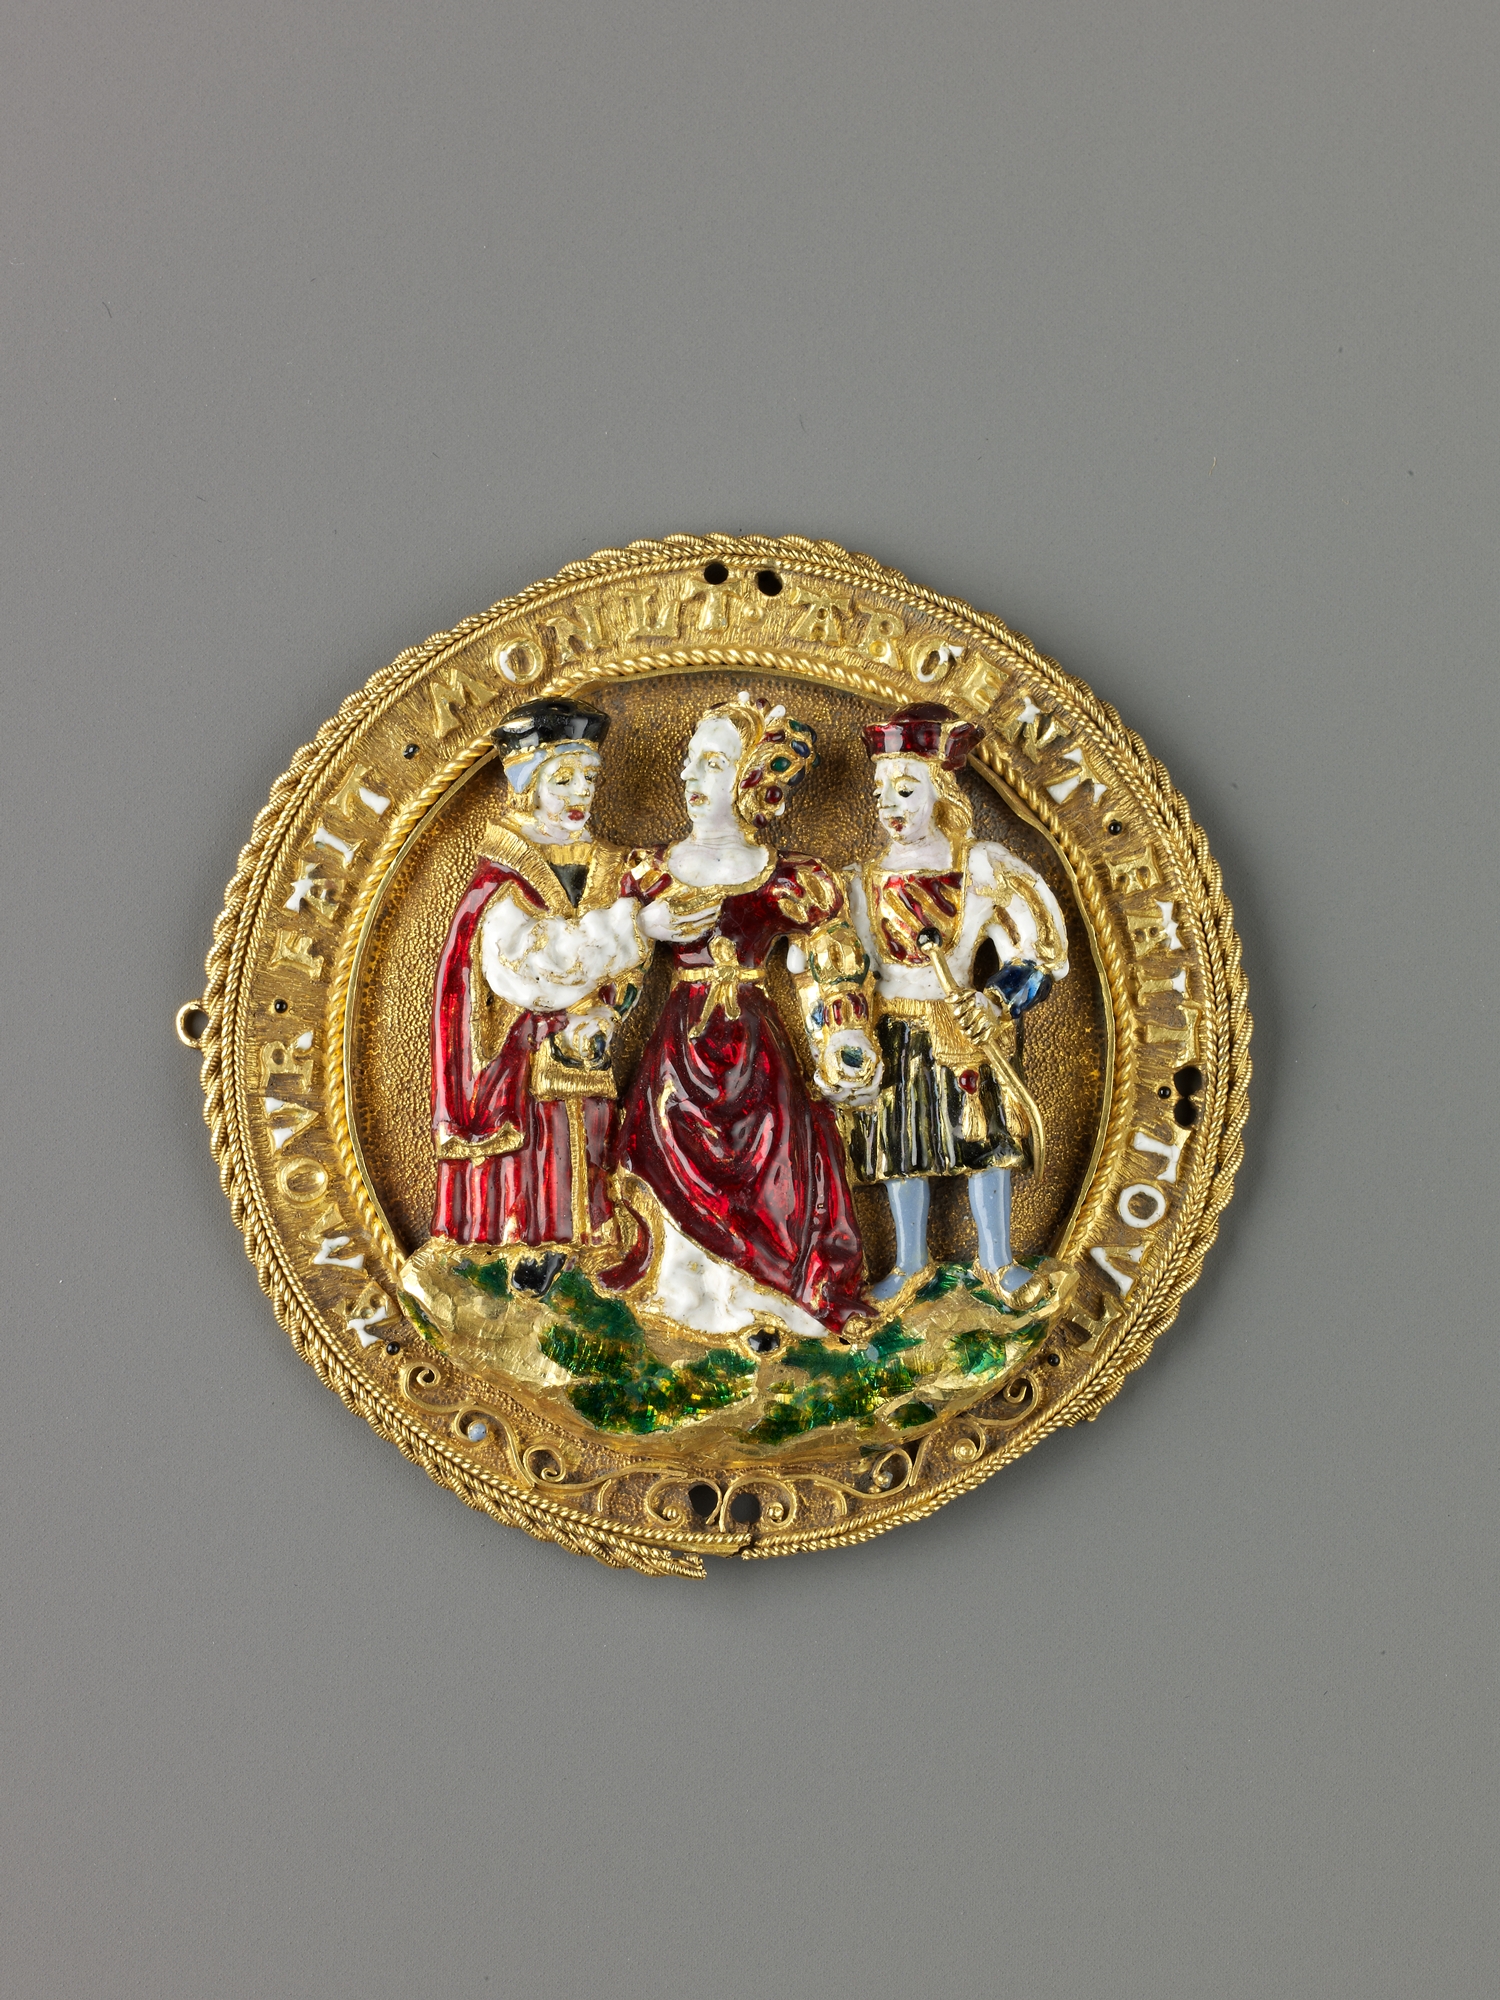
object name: hat ornament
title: Hat Badge: Woman Choosing Between Youth and Old Age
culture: flemish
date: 1520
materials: enamel, gold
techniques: filigree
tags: men,women